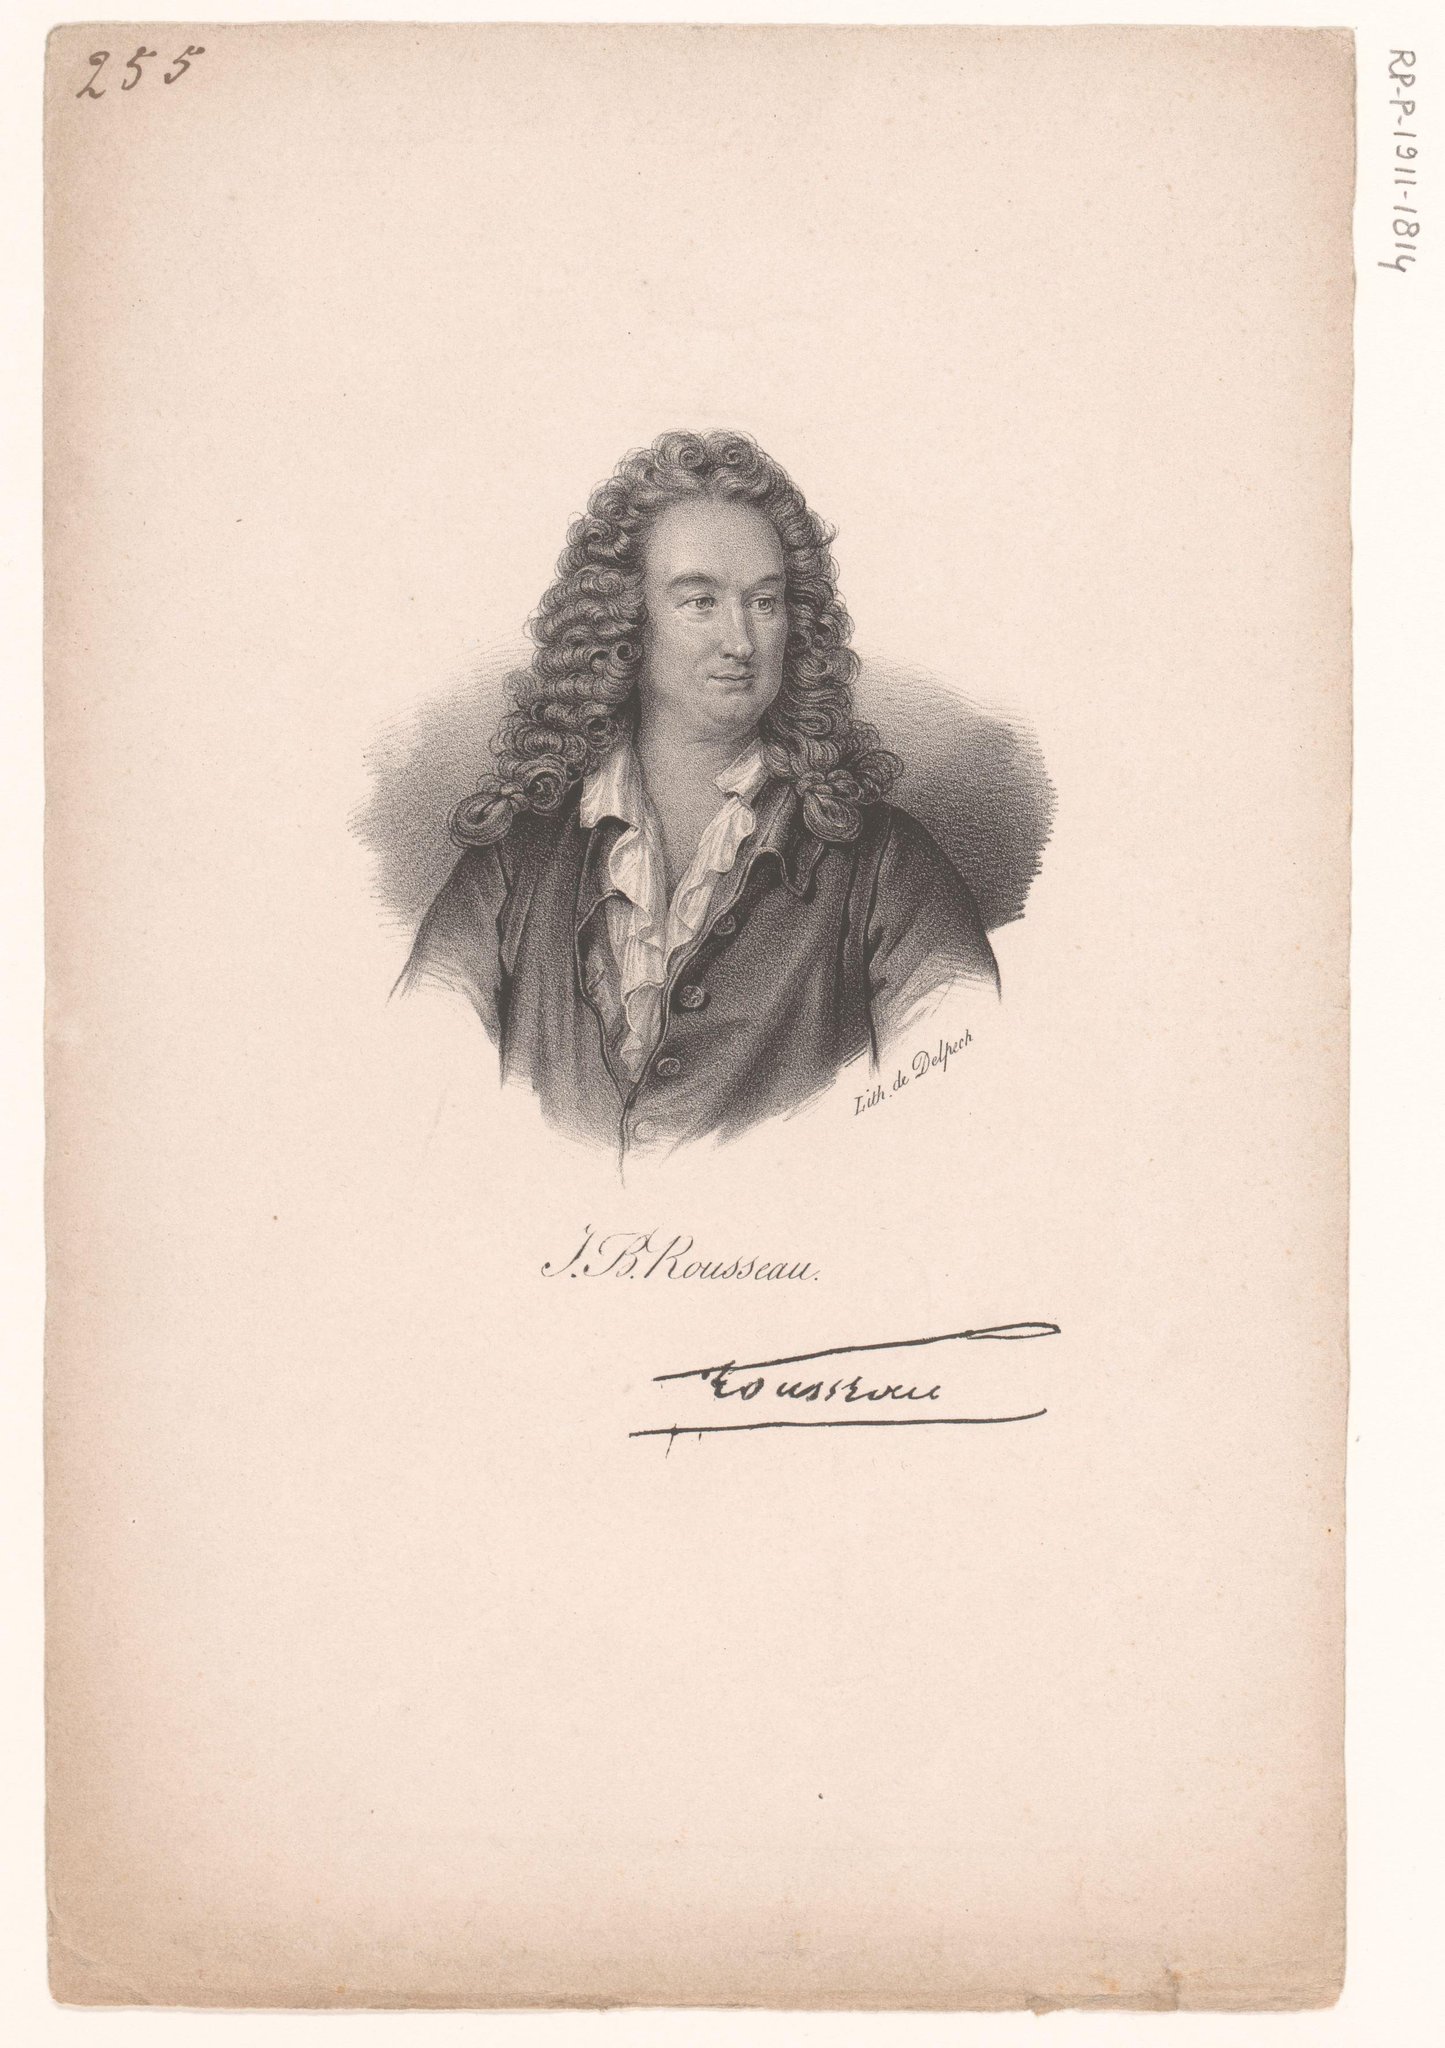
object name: print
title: Portret van Jean-Baptiste Rousseau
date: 1818-1842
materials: paper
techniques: lithograph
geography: paris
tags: paris, brussels, jean baptiste rousseau (1669-1741), historical persons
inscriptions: collector's mark: Lugt 2228a